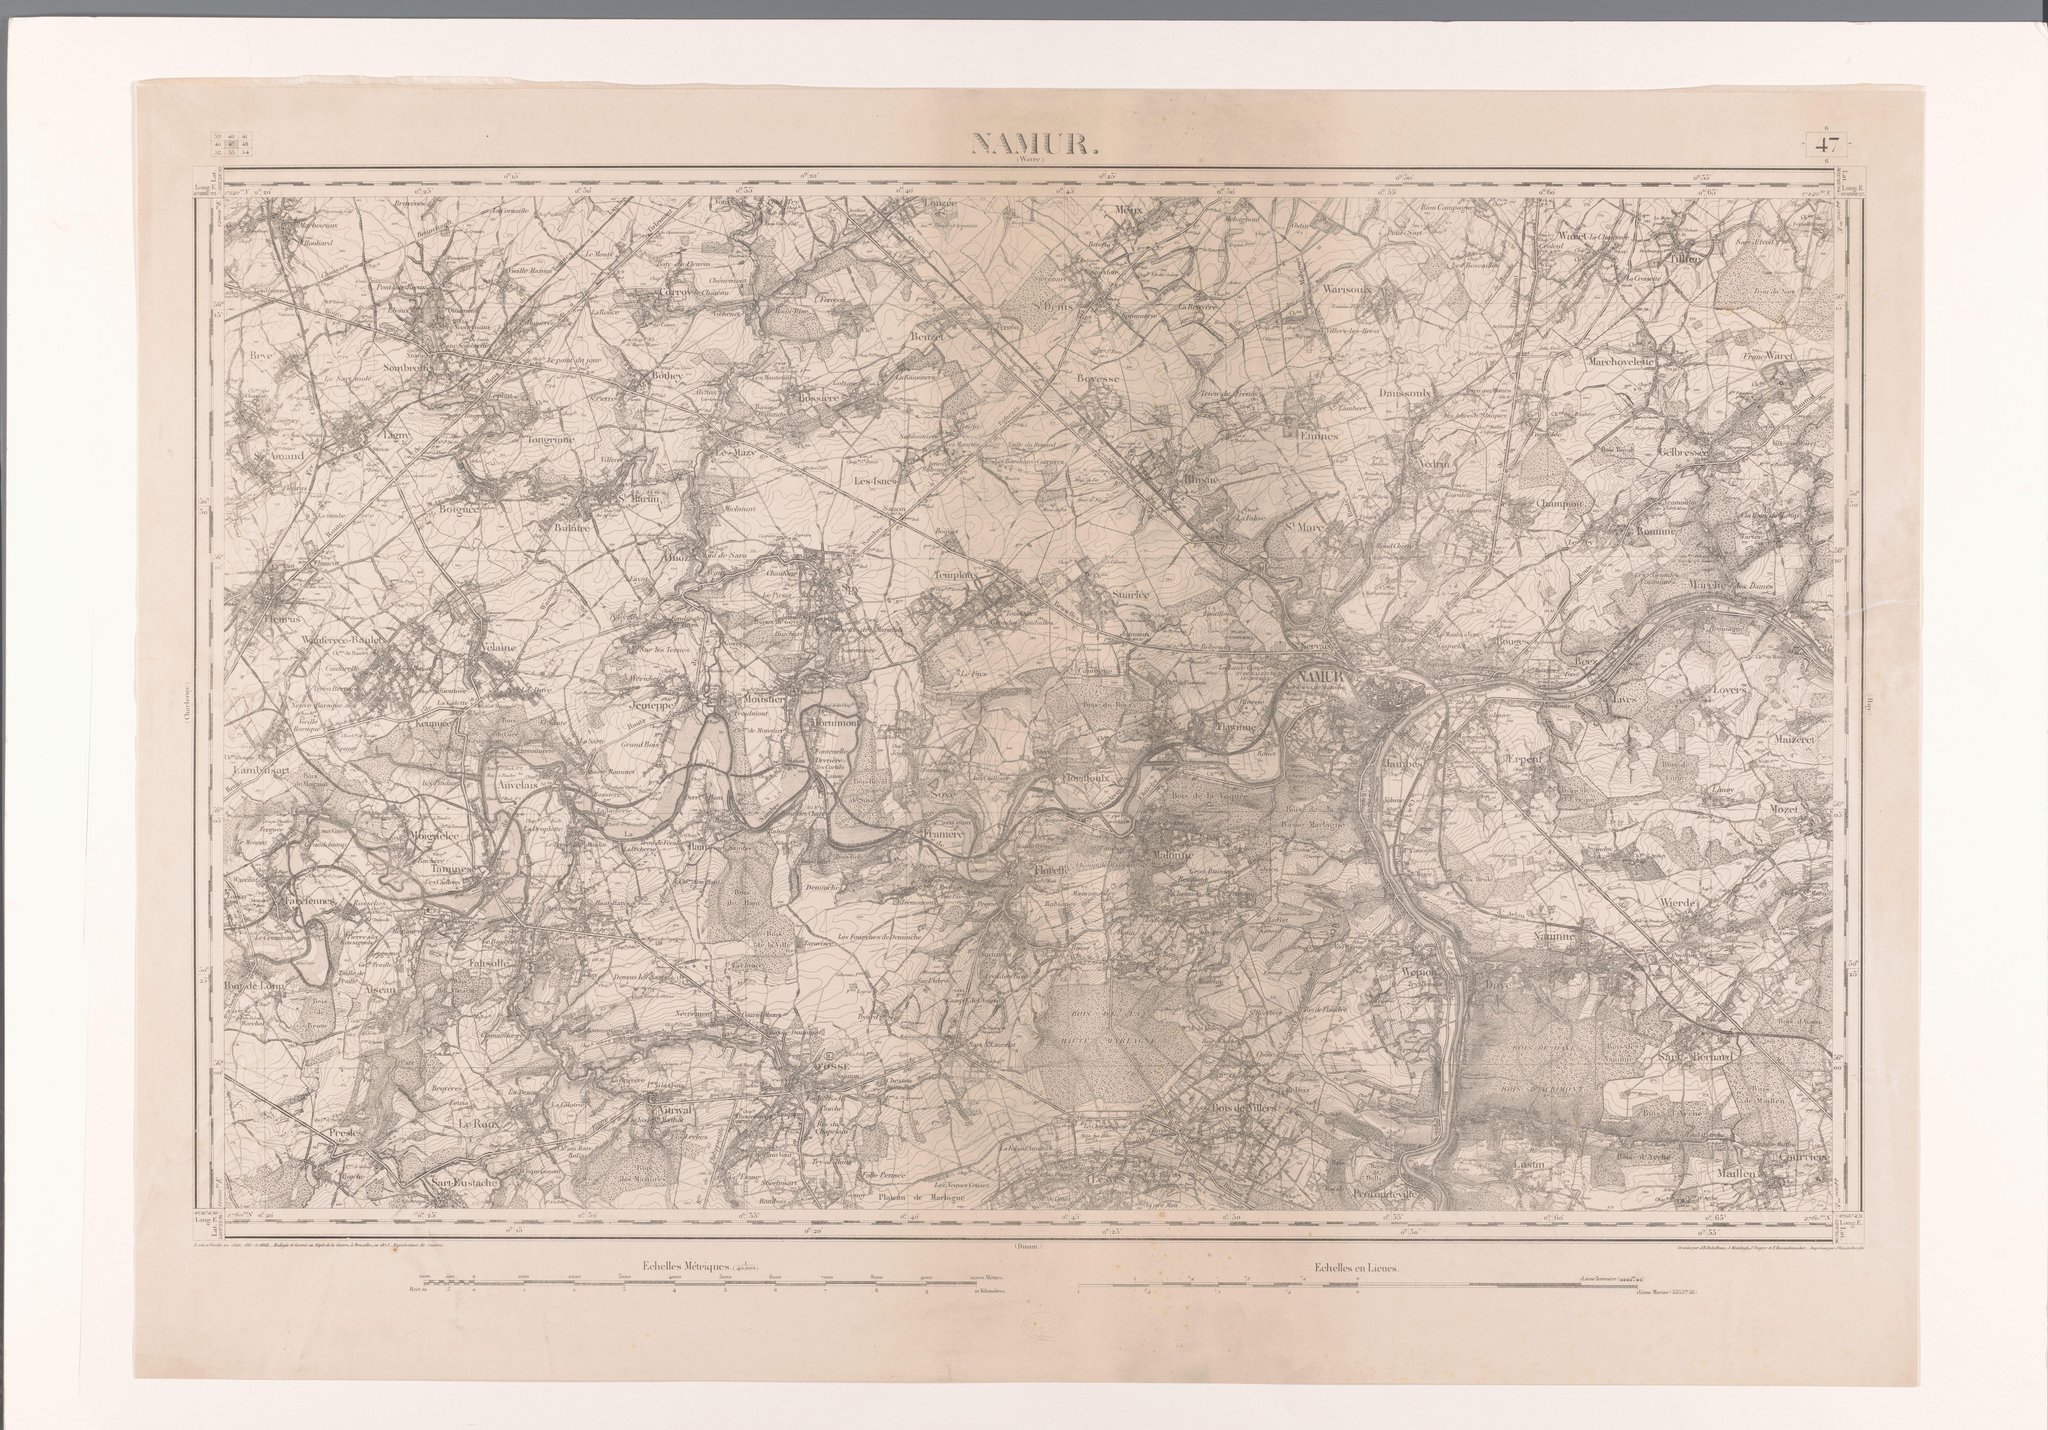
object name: map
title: Kaart van de omgeving van Namen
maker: j. vanderborght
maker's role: printer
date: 1873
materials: paper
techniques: lithograph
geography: brussels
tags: maps of separate countries or regions, namur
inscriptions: check stamp: ‘Depot de la Guerre Belgique’